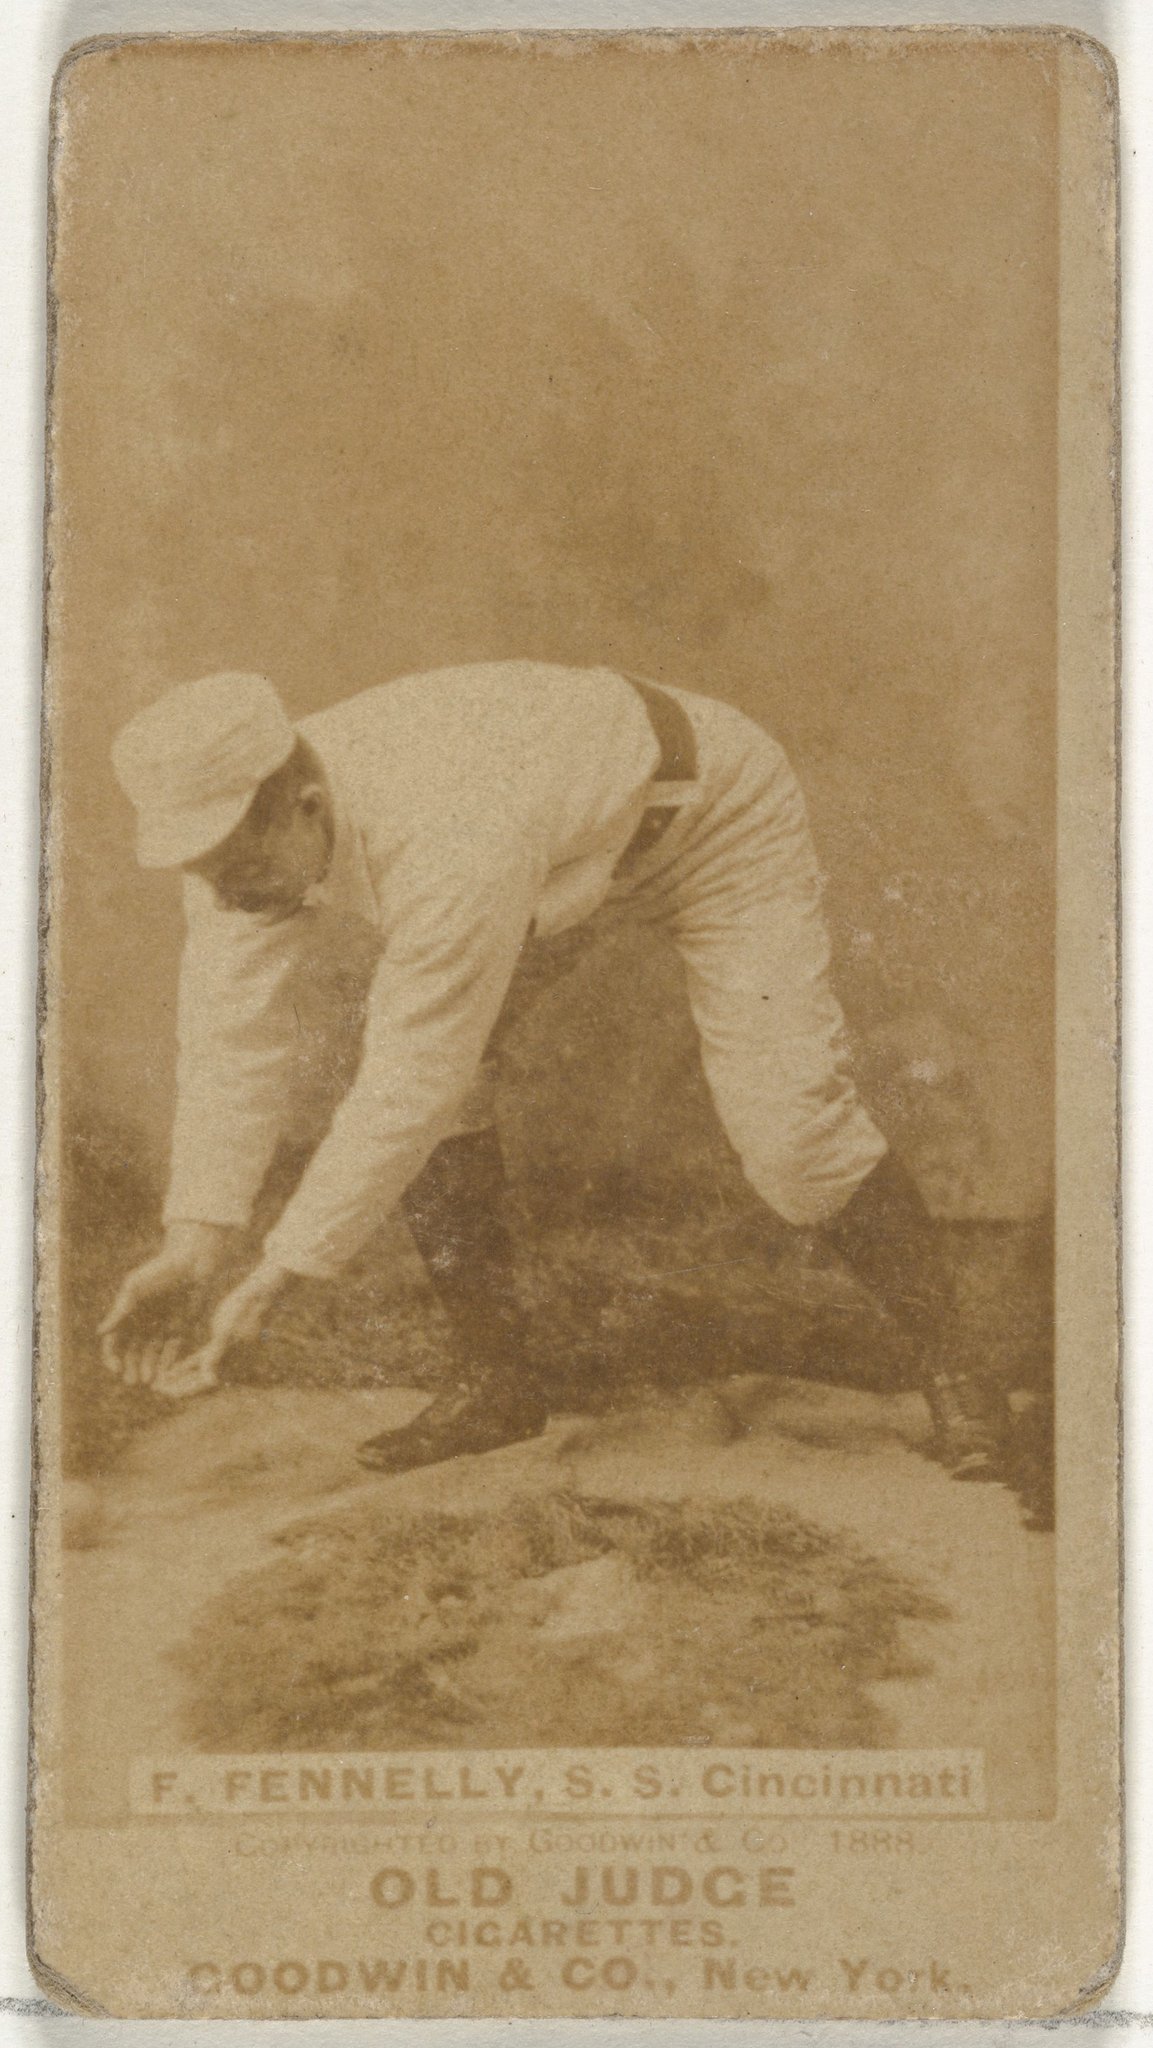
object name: baseball card, photograph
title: Francis John "Frank" Fennelly, Shortstop, Cincinnati, from the Old Judge series (N172) for Old Judge Cigarettes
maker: goodwin & company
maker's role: publisher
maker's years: 1850-1950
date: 1888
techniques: albumen silver print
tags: men,portraits,baseball,athletes